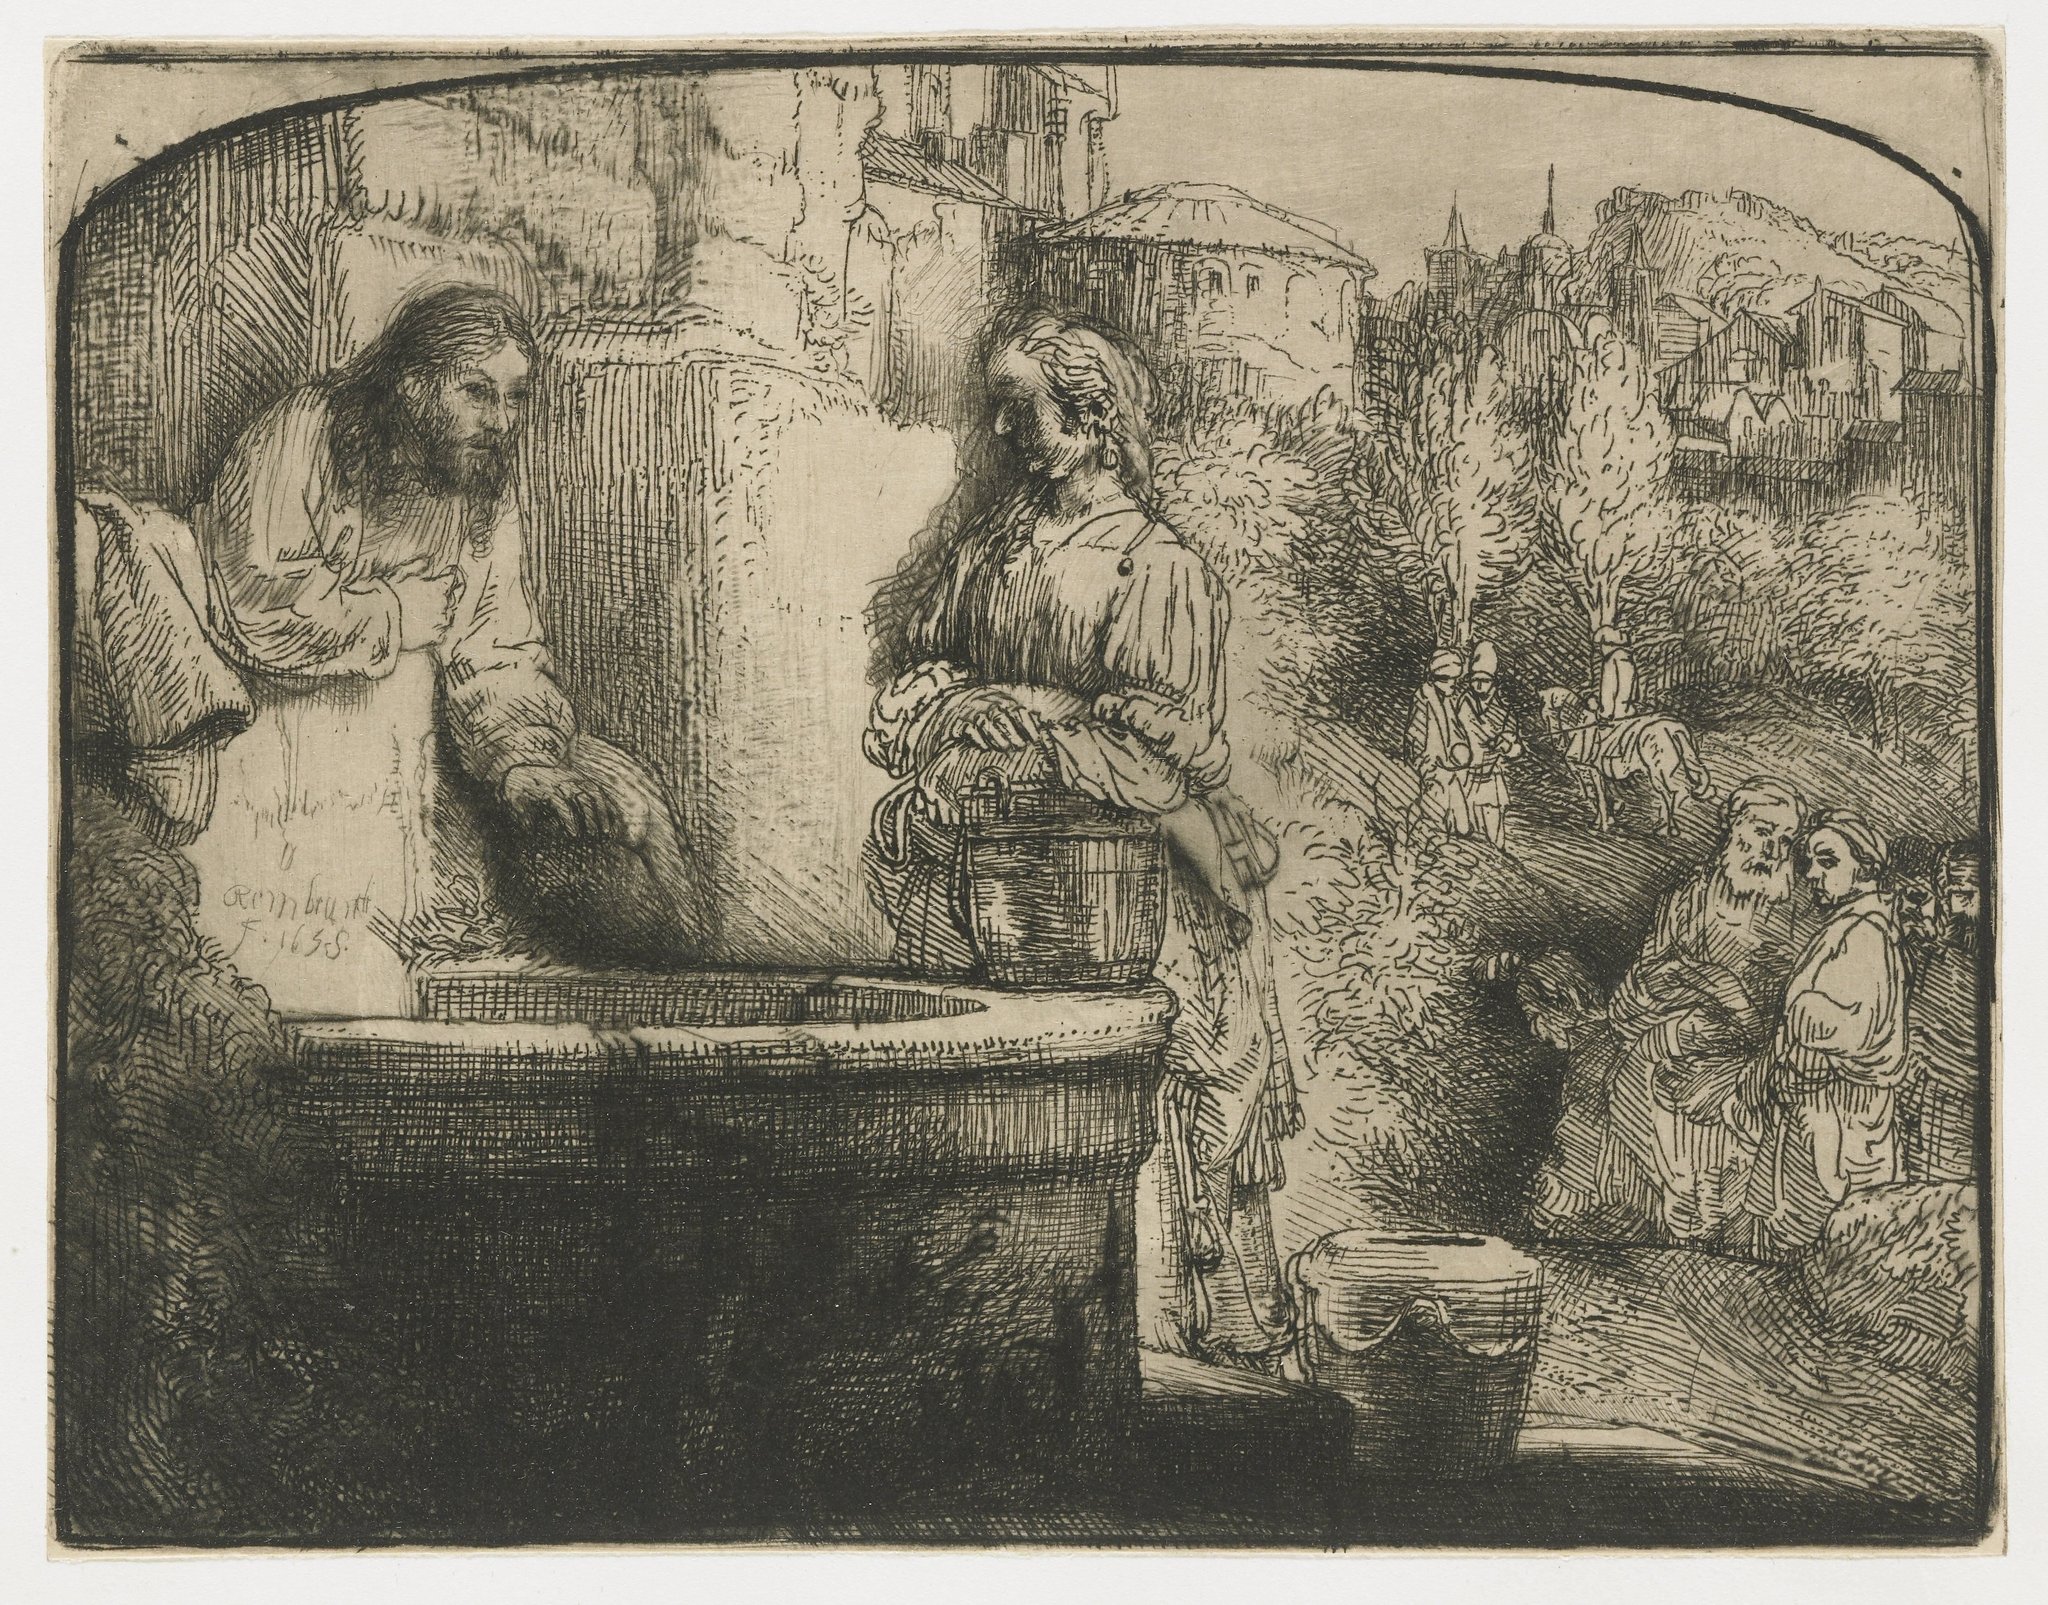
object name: print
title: Christ and the woman of Samaria: an arched print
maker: rembrandt van rijn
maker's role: draughtsman, painter, print maker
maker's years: 1606-1669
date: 1657-1658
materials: paper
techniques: drypoint, etching, intaglio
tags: the woman of samaria (john 4:4-42)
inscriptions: collector's mark: Lugt 240, signature and date: ‘Rembrandt f. 1657’, signature and date: ‘Rembrandt f. 1658’